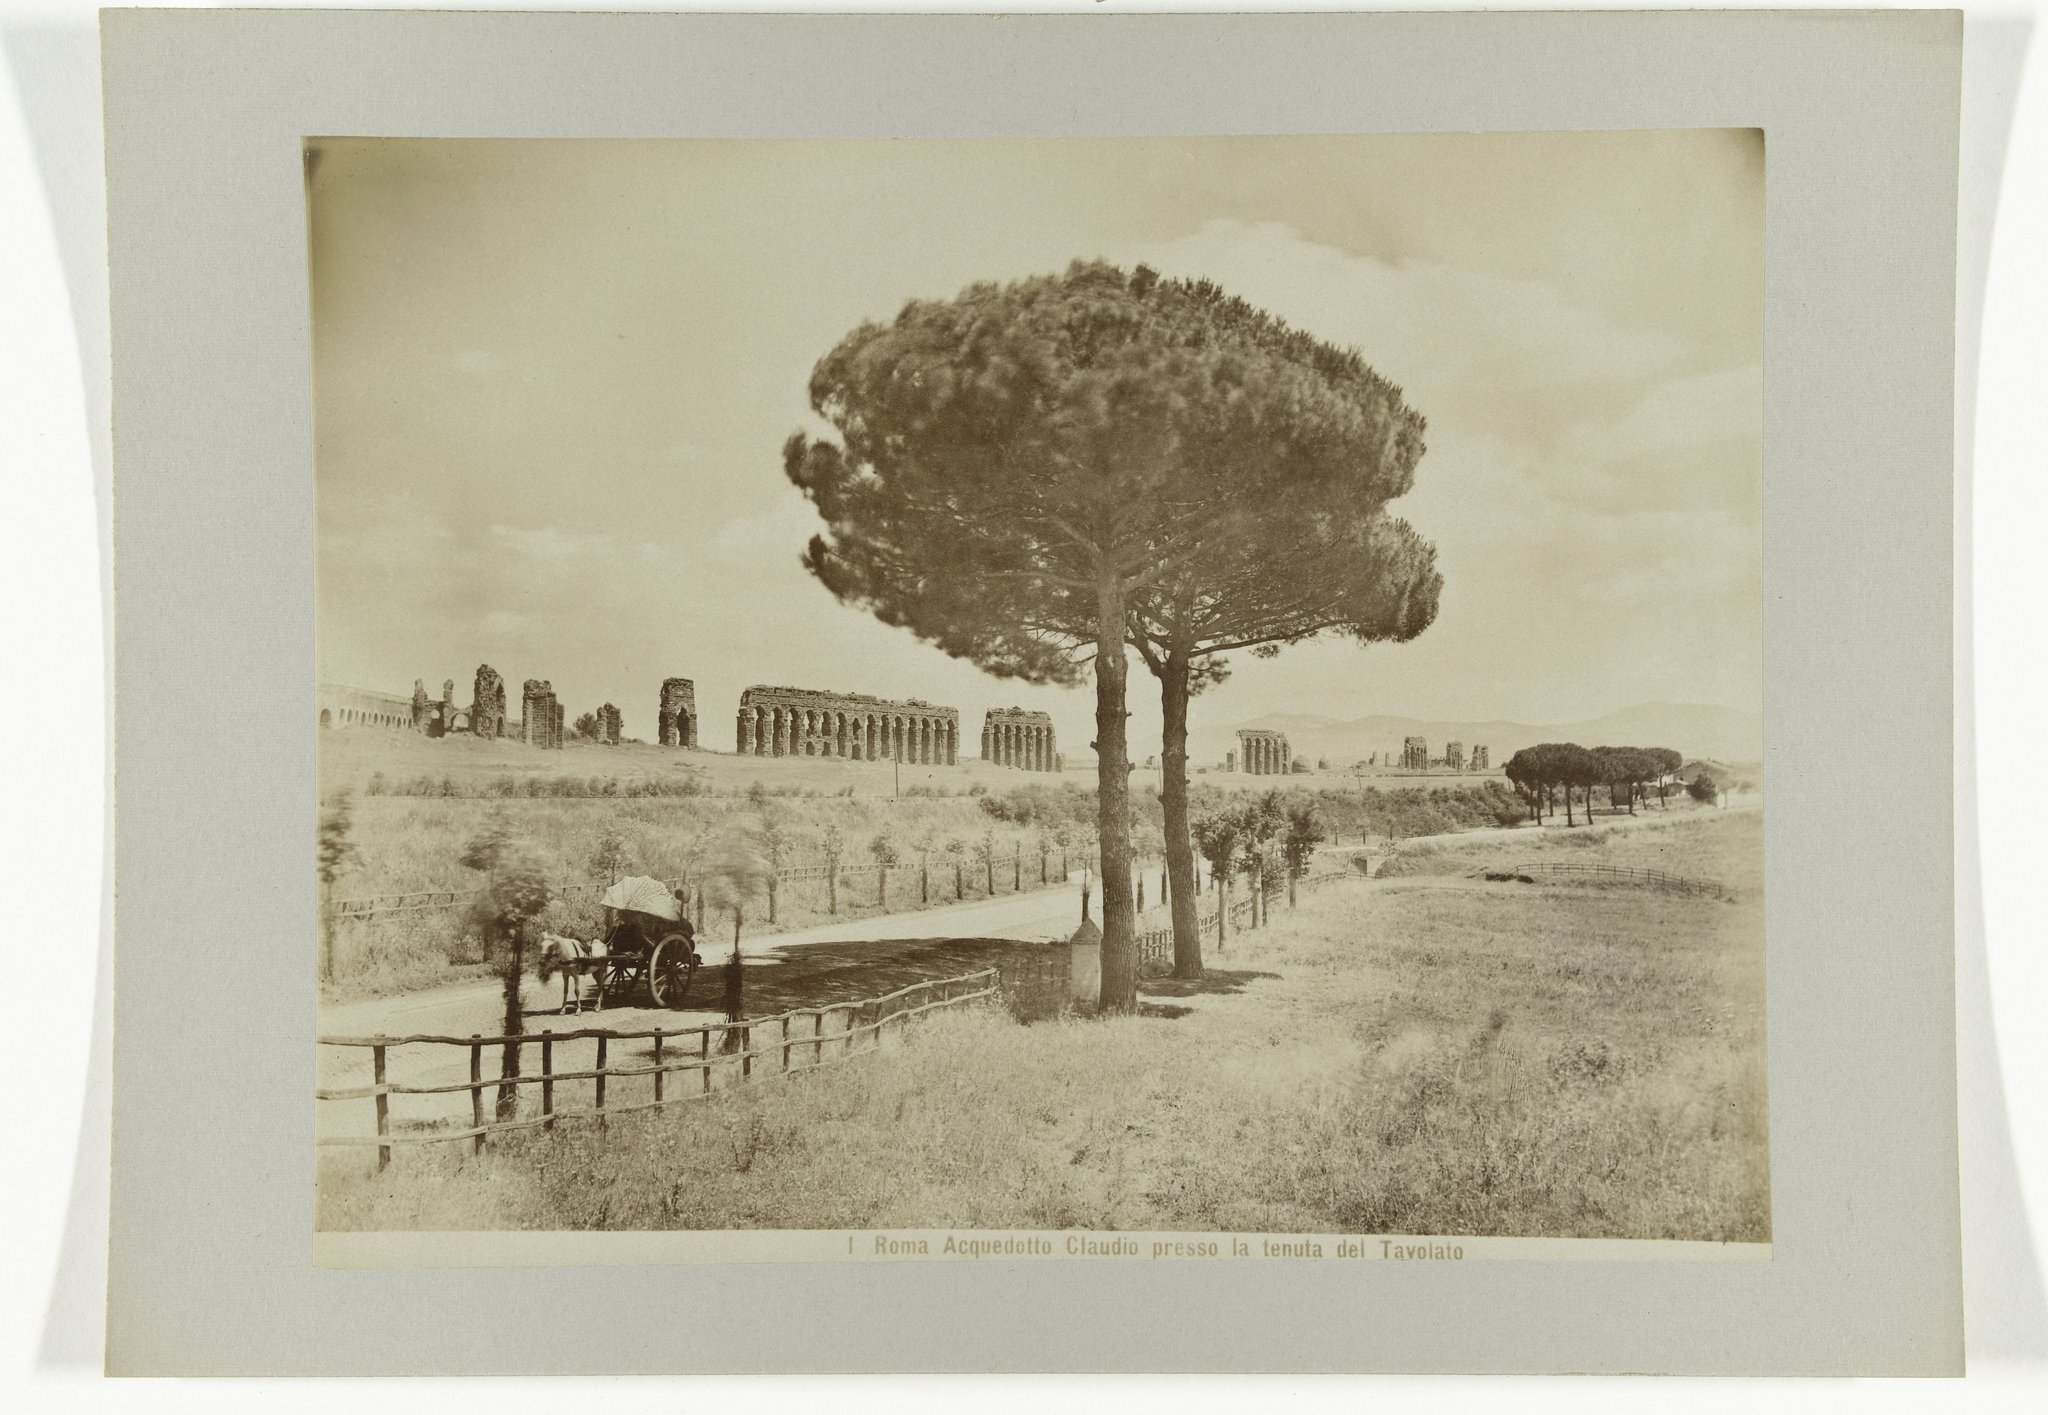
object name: photograph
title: I Roma Acquedotto Claudio presso la tenuta del Tavolato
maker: Anonymous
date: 1880-1904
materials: cardboard, paper, photographic support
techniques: albumen print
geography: rome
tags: aqua claudia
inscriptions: number: ‘25.’